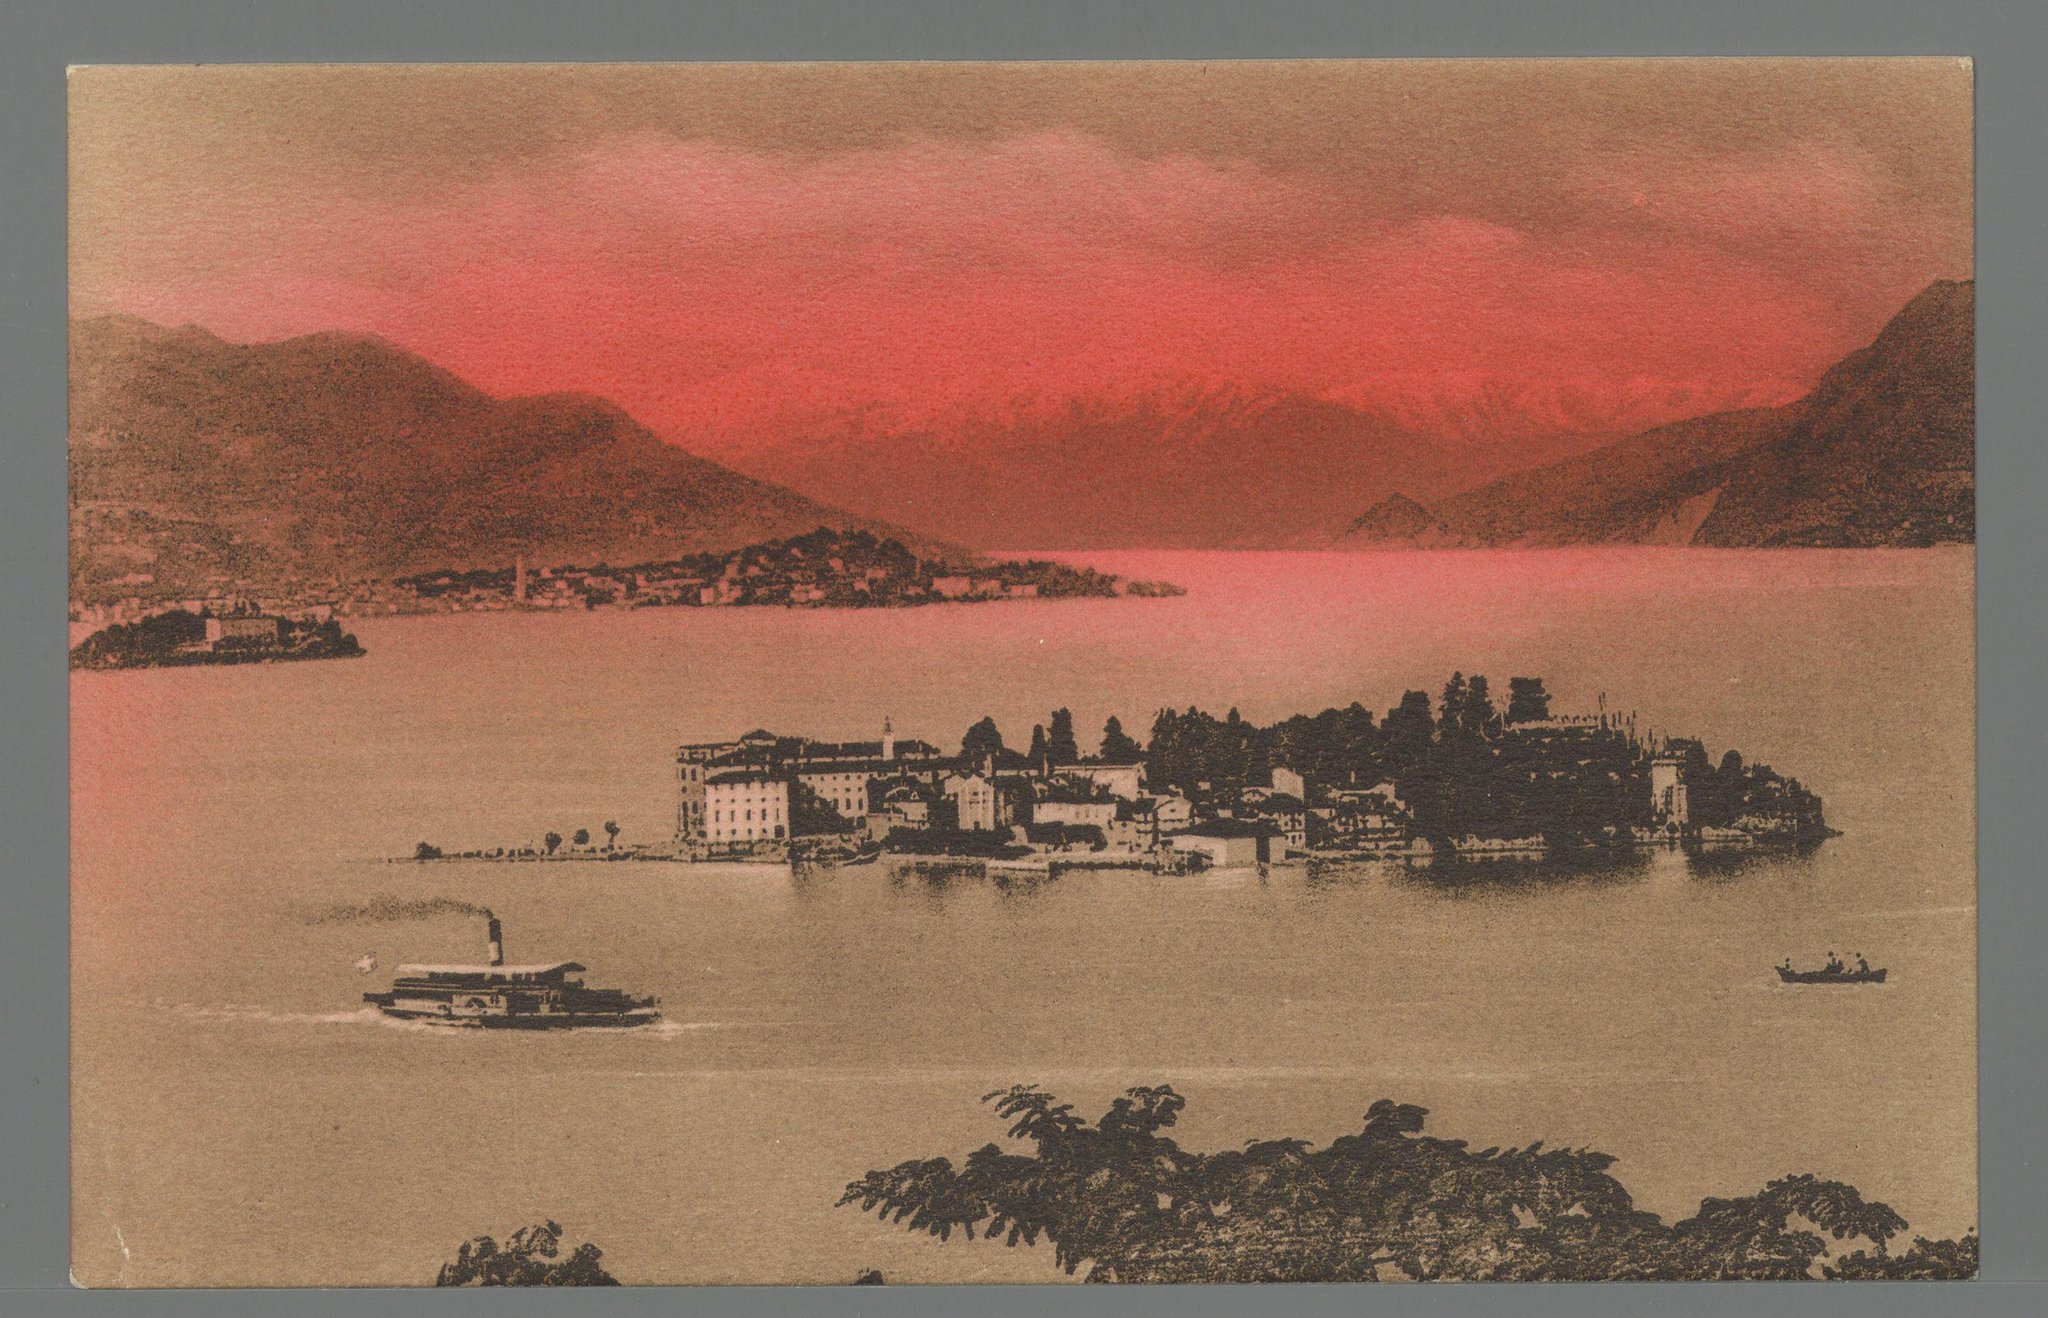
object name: ansichtkaart, prentbriefkaart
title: Isola Bella, Isola Madre e Pallanza. Lago Maggiore, tramonto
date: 1905-1909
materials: cardboard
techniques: photograph, lithograph, writing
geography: como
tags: island, lake, sunset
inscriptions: monogram: ‘S.G.’